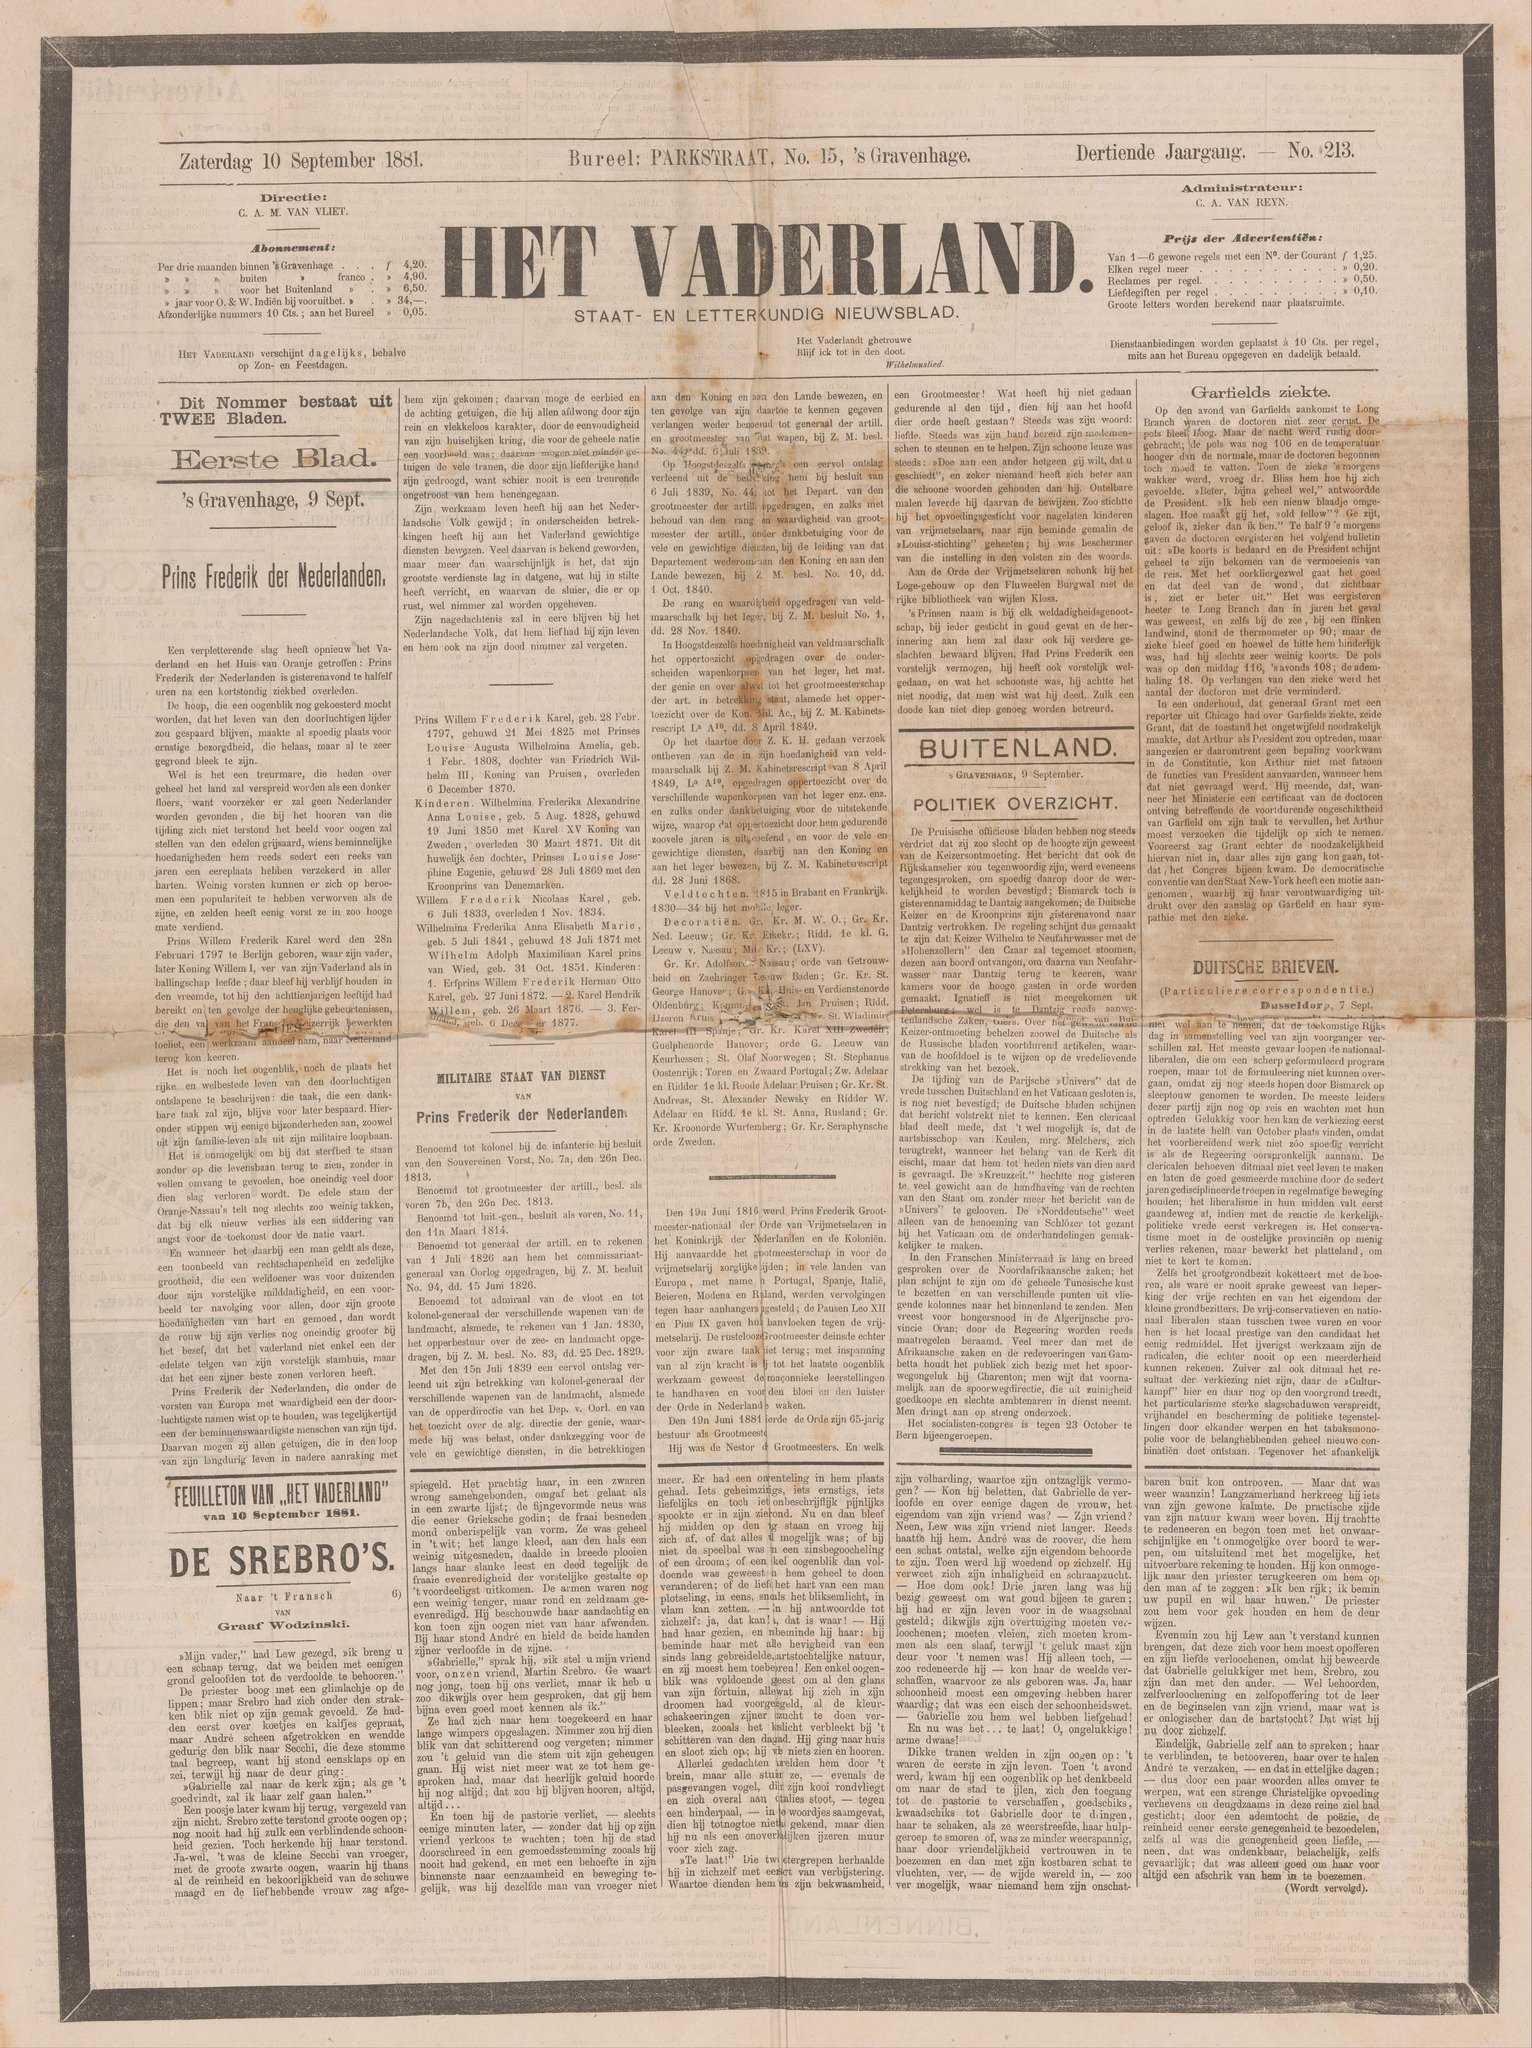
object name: newspaper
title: Het Vaderland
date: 1881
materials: paper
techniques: printing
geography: the hague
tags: frederik (prins der nederlanden), netherlands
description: Krant nr. 213 van de 13e jaargang van "Het Vaderland", 6 pp, voorpagina in zwarte kadering, met bericht overlijden prins Frederik.